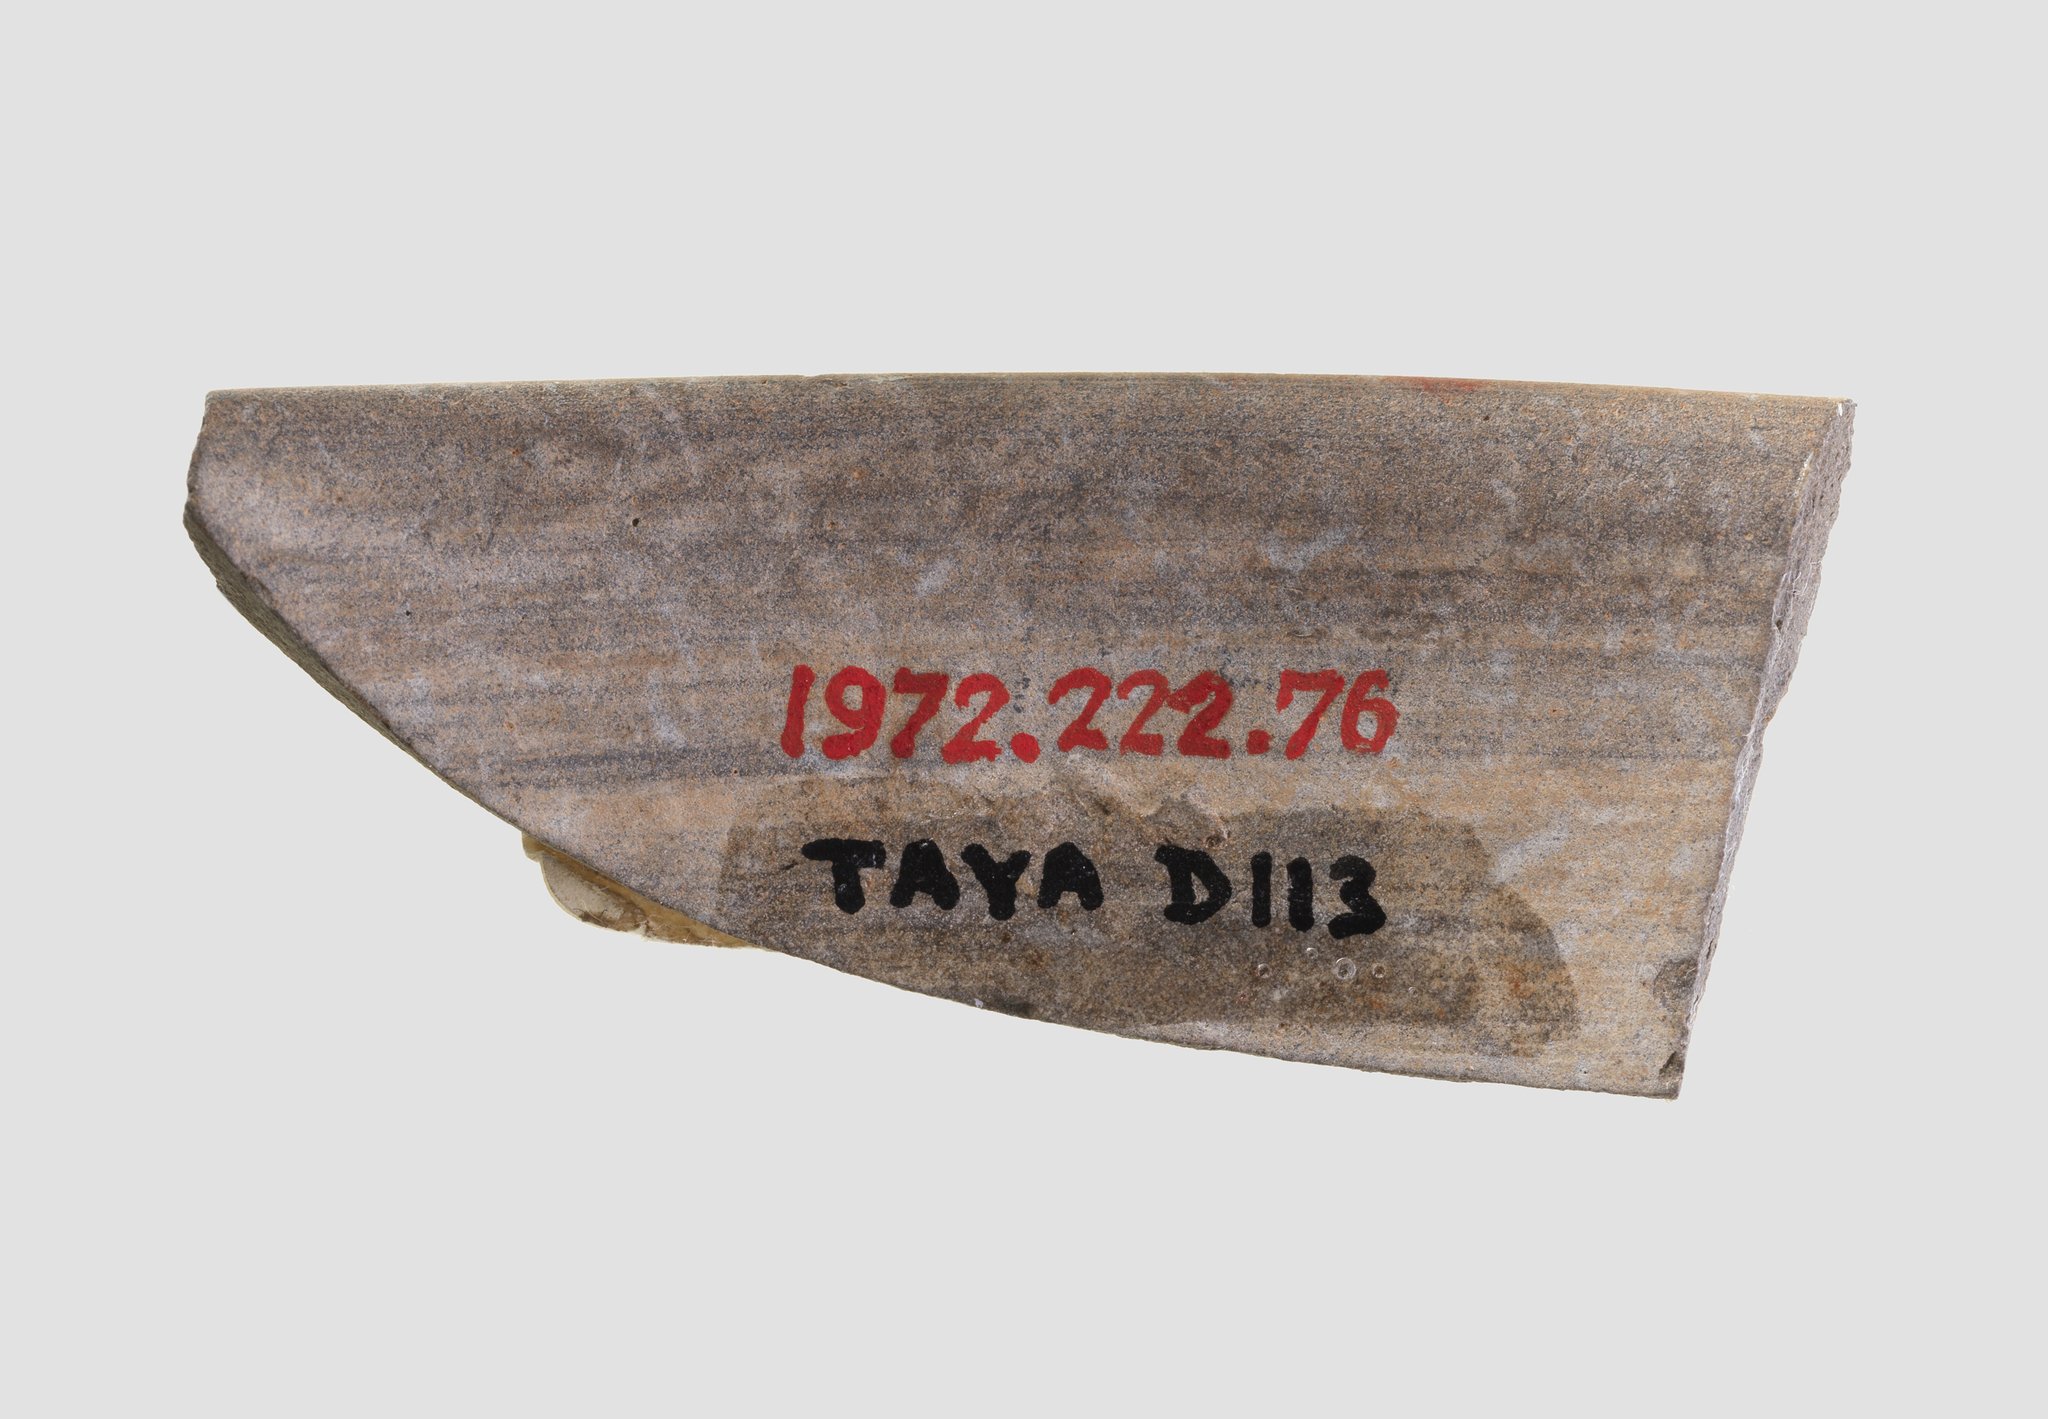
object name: sherd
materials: ceramic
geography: mesopotamia